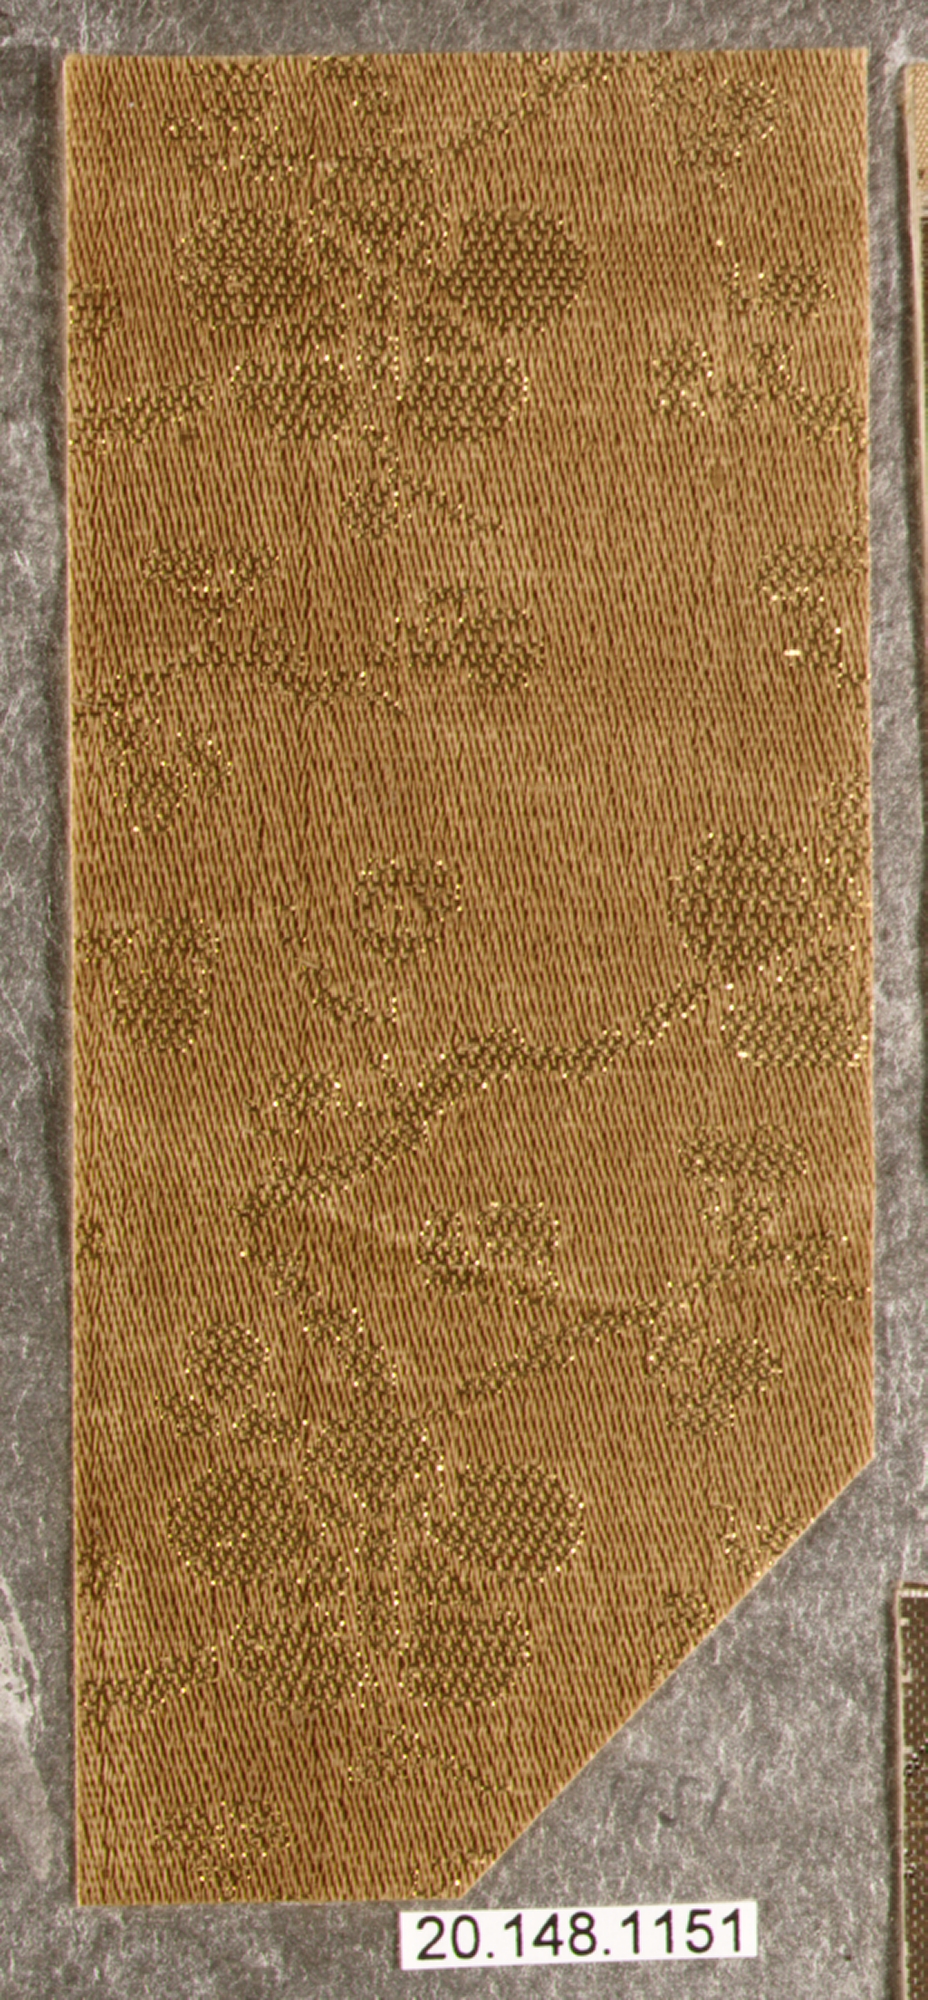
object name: piece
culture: japanese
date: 1801-1900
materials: silk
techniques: compound weave